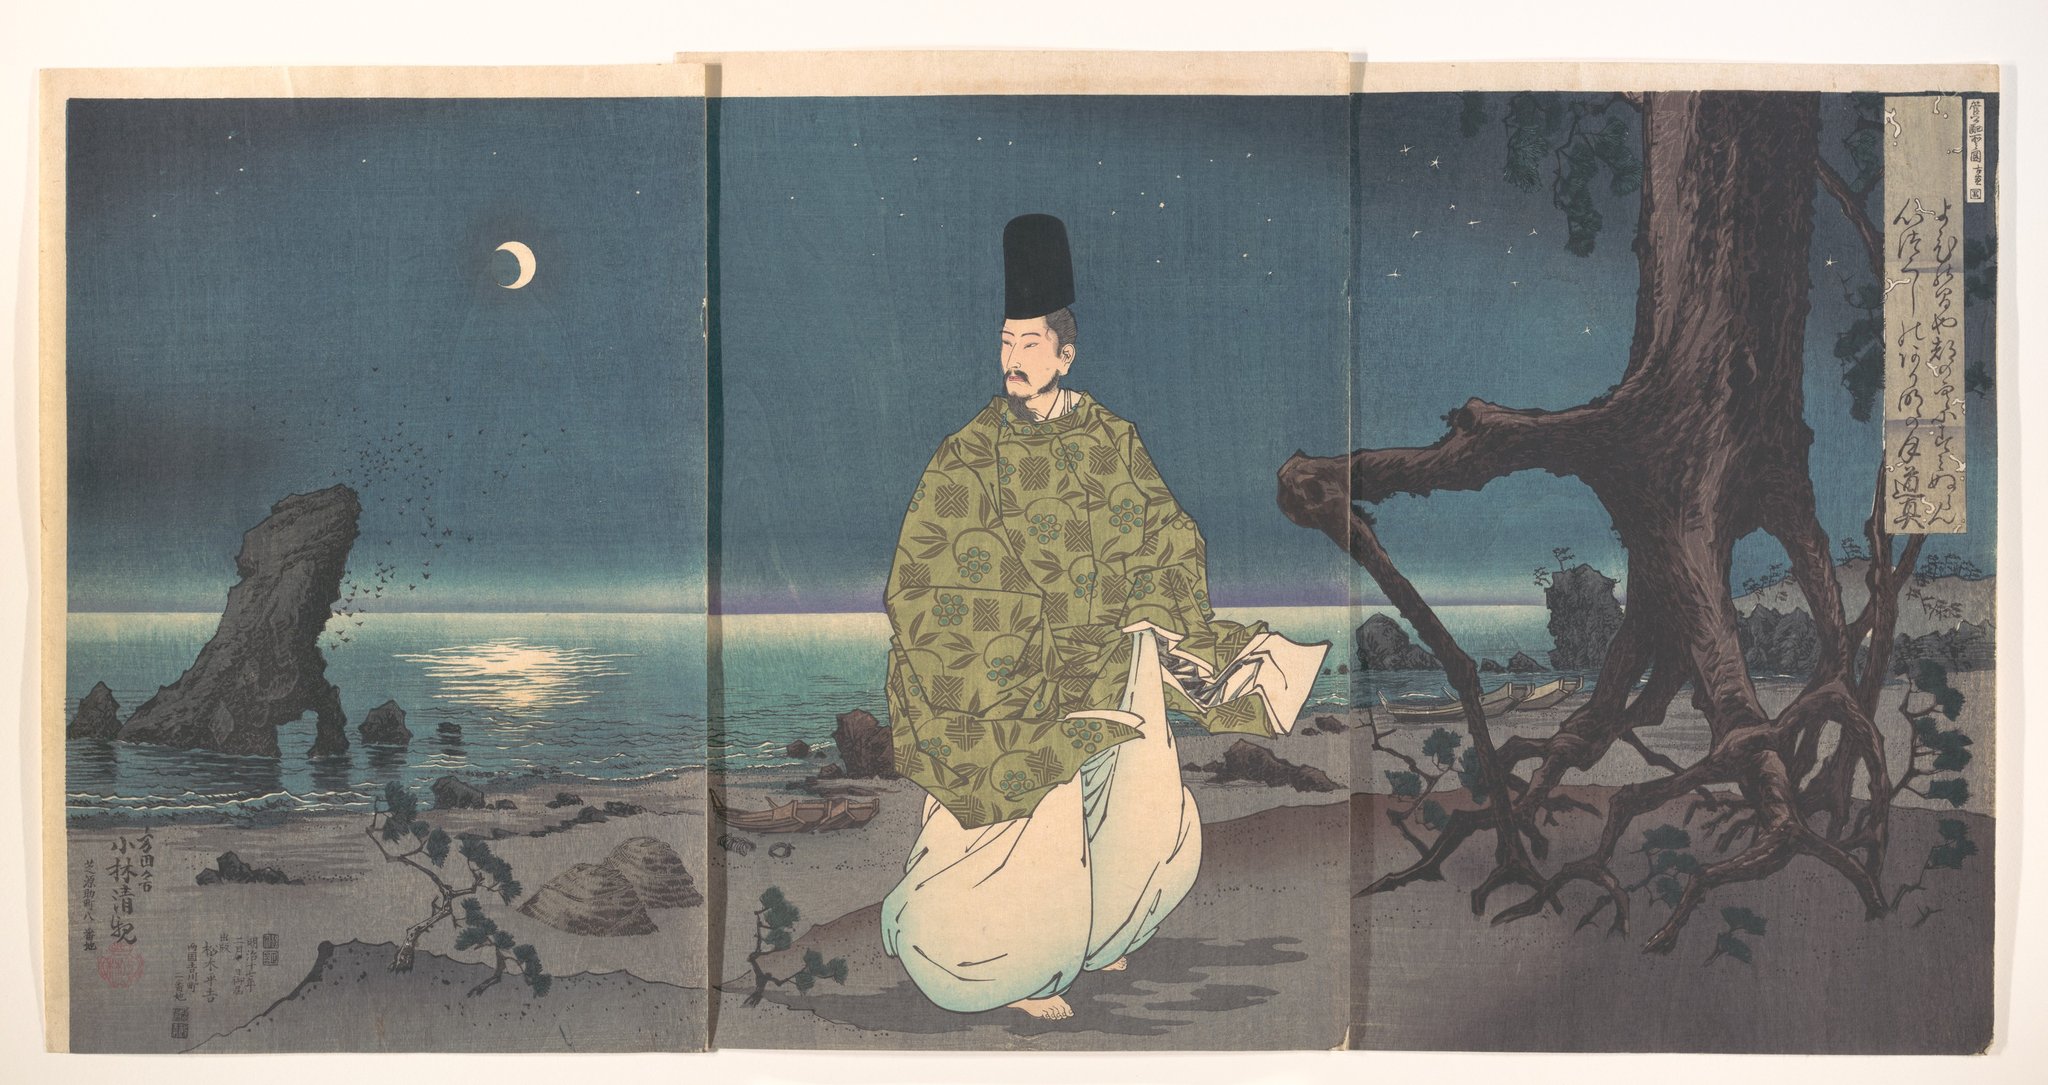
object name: print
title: Heian Period Courtier on a Moonlit Beach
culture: japanese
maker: kobayashi kiyochika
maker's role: artist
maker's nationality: japanese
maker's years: 1847-1915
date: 1801-1900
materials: ink, paper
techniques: woodblock print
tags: men,beaches